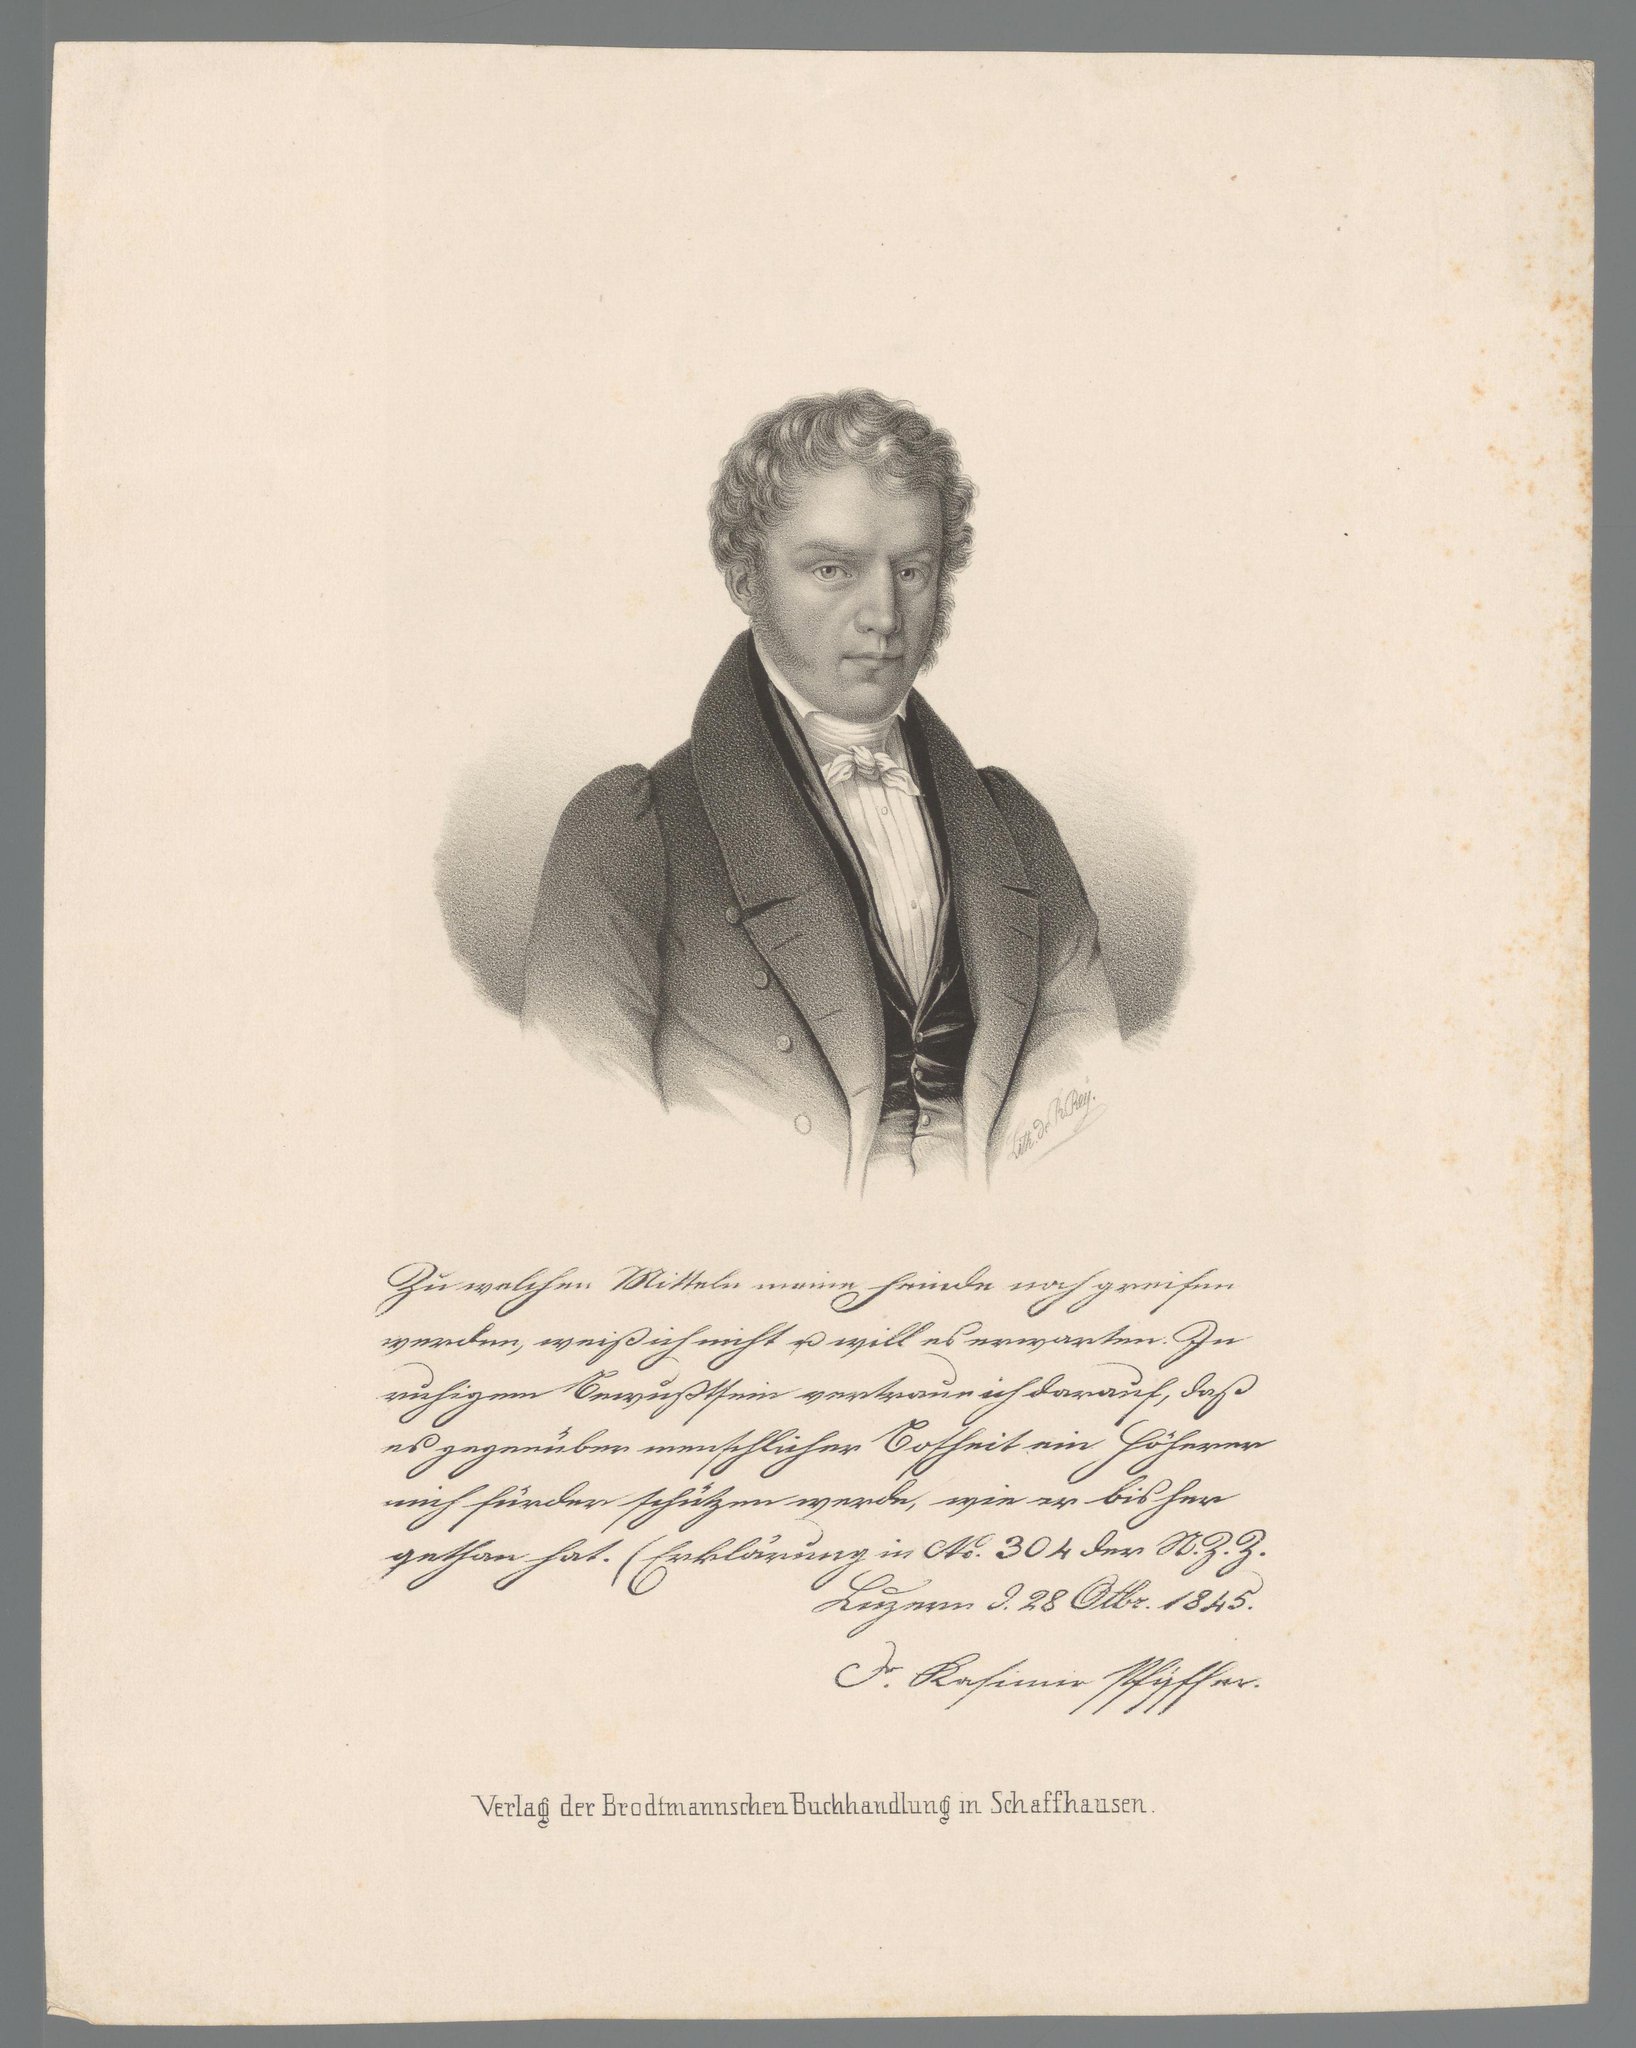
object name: print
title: Portret van Casimir Pfyffer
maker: rudolf rey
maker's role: print maker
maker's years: 1814-1897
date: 1824-1897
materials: paper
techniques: lithograph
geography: schaffhausen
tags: rome, politician, historical persons, politician, e.g. party leader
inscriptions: collector's mark: Lugt 2228